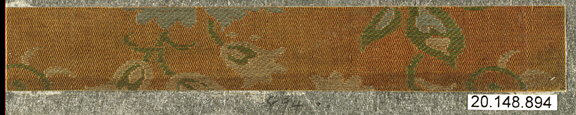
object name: piece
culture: chinese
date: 1701-1800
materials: silk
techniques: compound weave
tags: flowers